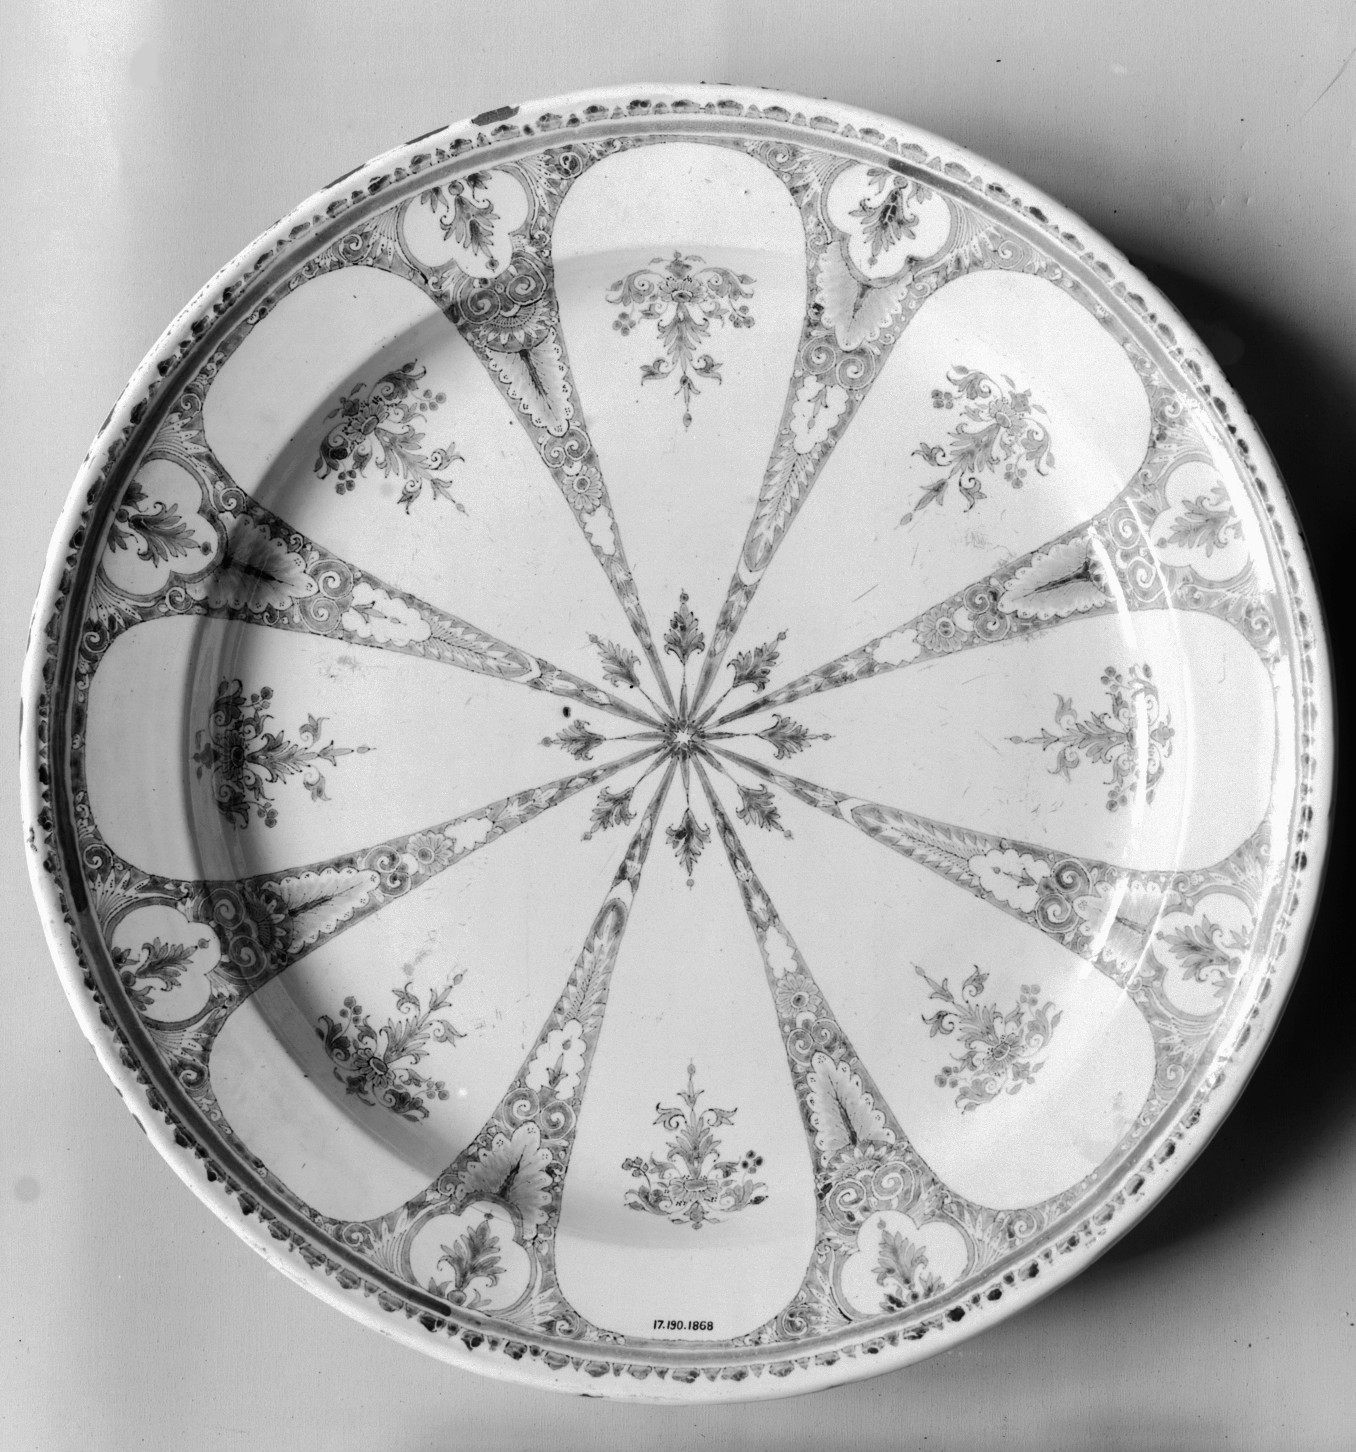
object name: plateau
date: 1710-1720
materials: faience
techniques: glazing